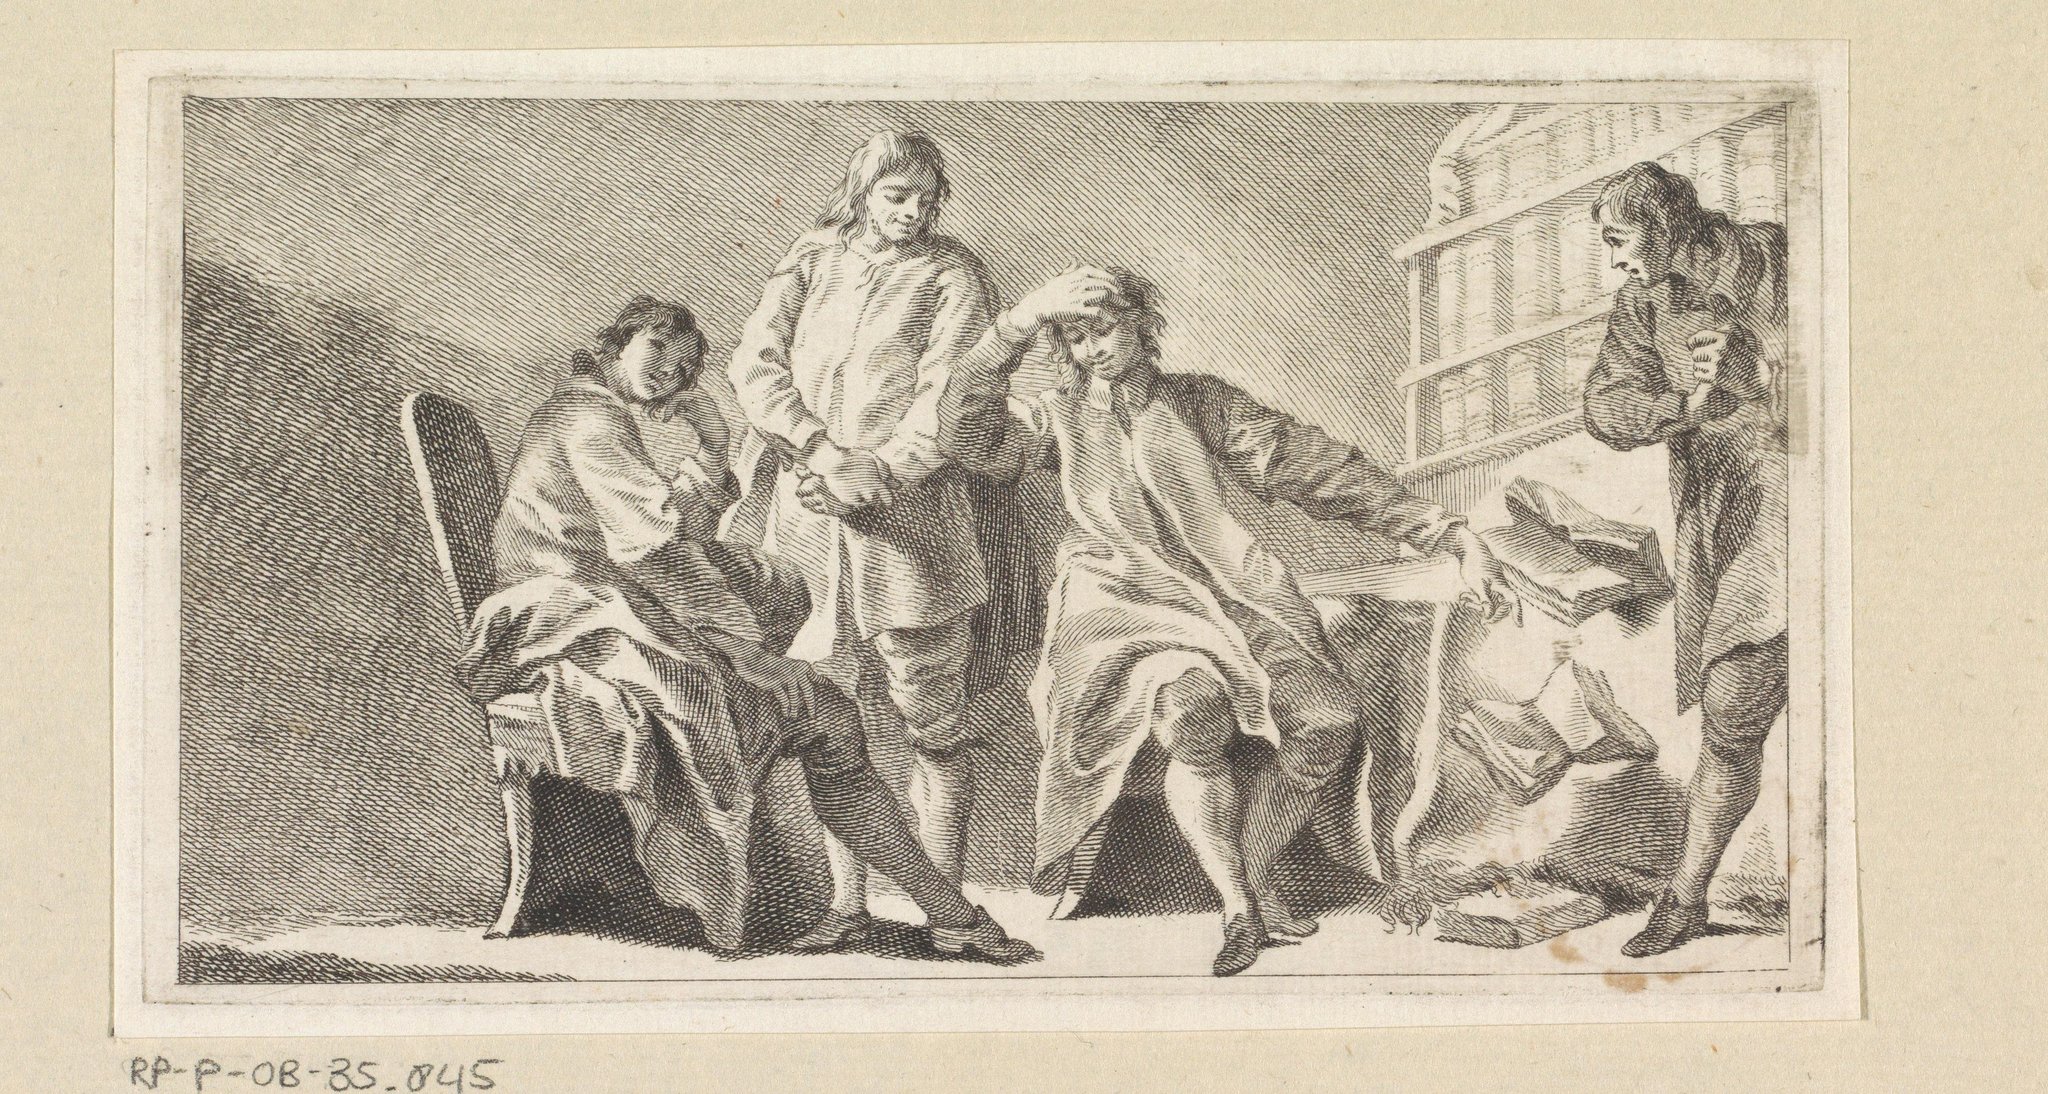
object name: print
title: Vier mannen in een studeerkamer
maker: giovanni cattini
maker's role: print maker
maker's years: 1725-1800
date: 1735-1800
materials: paper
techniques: engraving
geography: italy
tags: study; 'studiolo'; library, book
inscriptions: collector's mark: Lugt 240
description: Twee zittende en twee staande mannen in een studeerkamer. Een man laat een stapel boeken op de grond vallen.